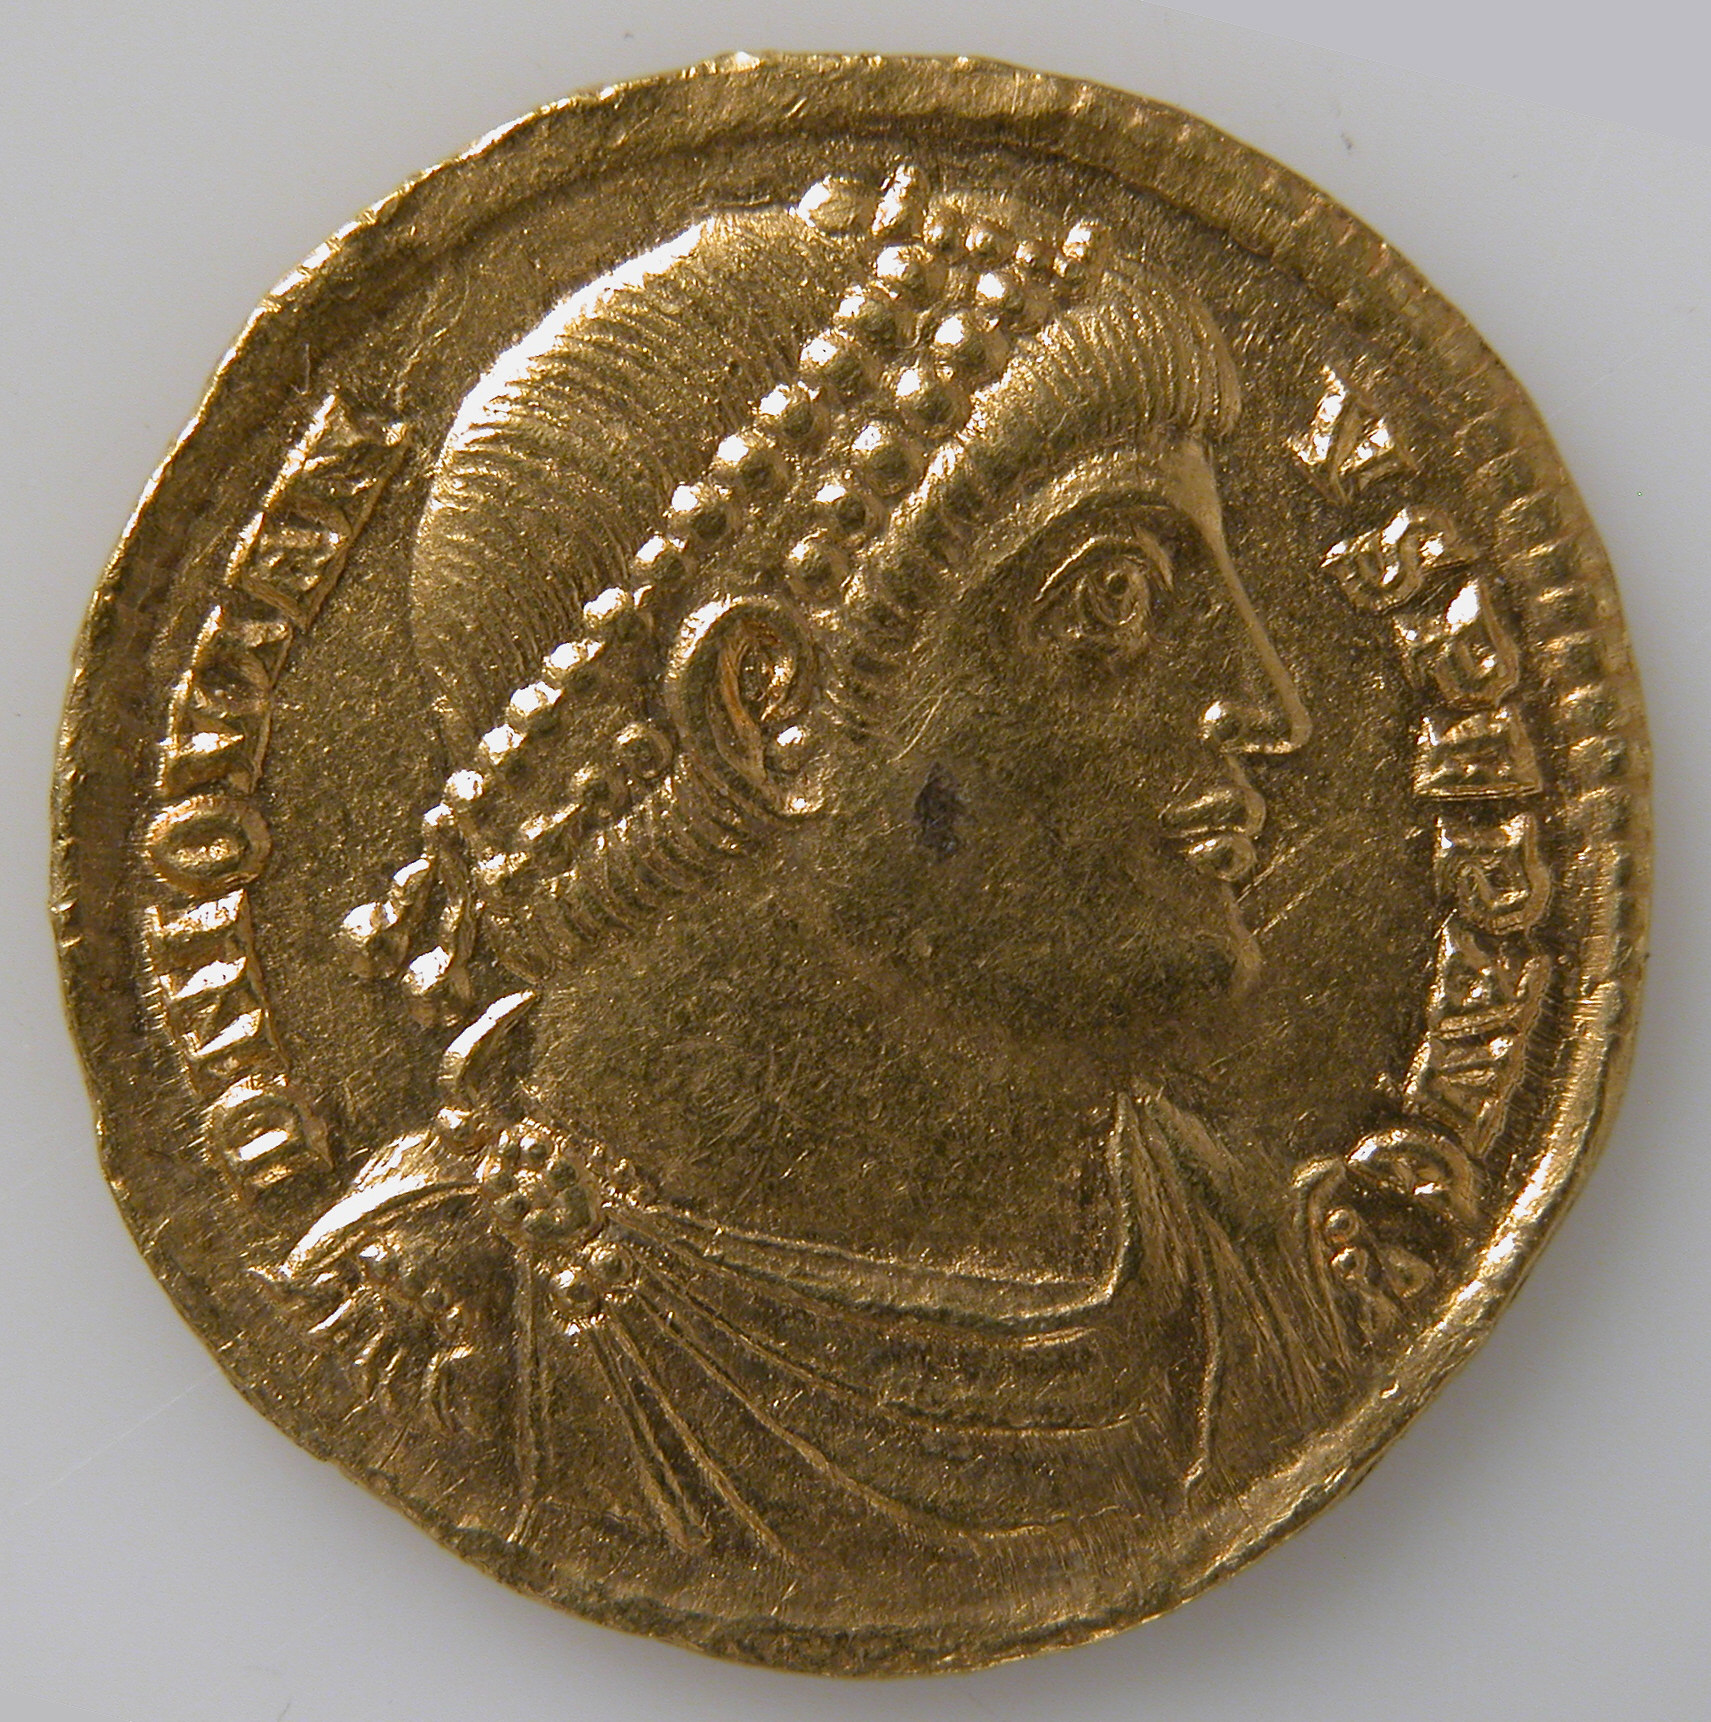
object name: solidus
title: Solidus of Jovian (r. 363–364)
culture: byzantine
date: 363-364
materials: gold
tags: men,profiles